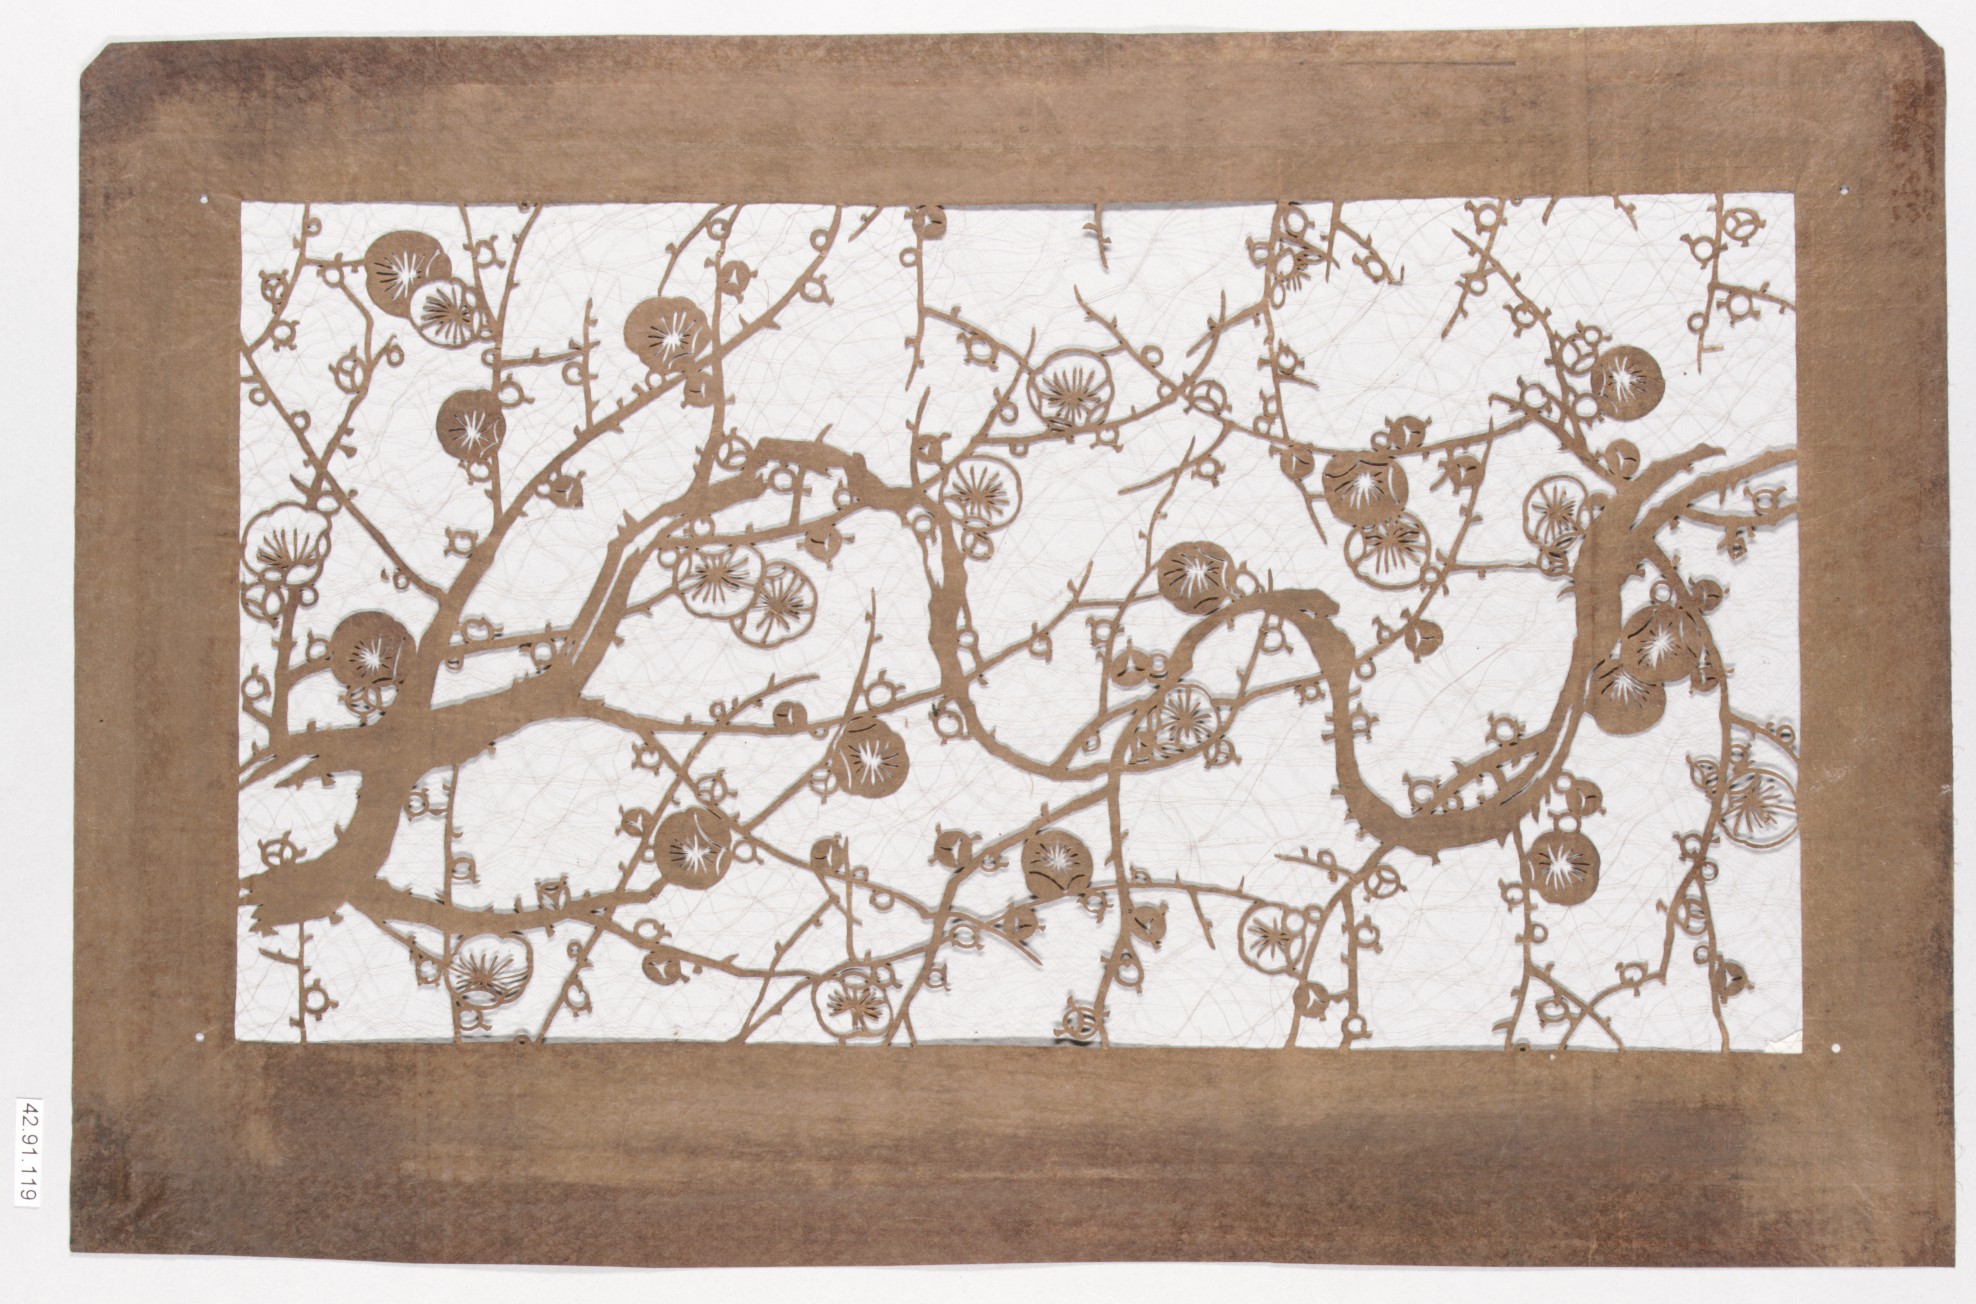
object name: stencil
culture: japanese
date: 1868-1912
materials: paper, silk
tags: flowers